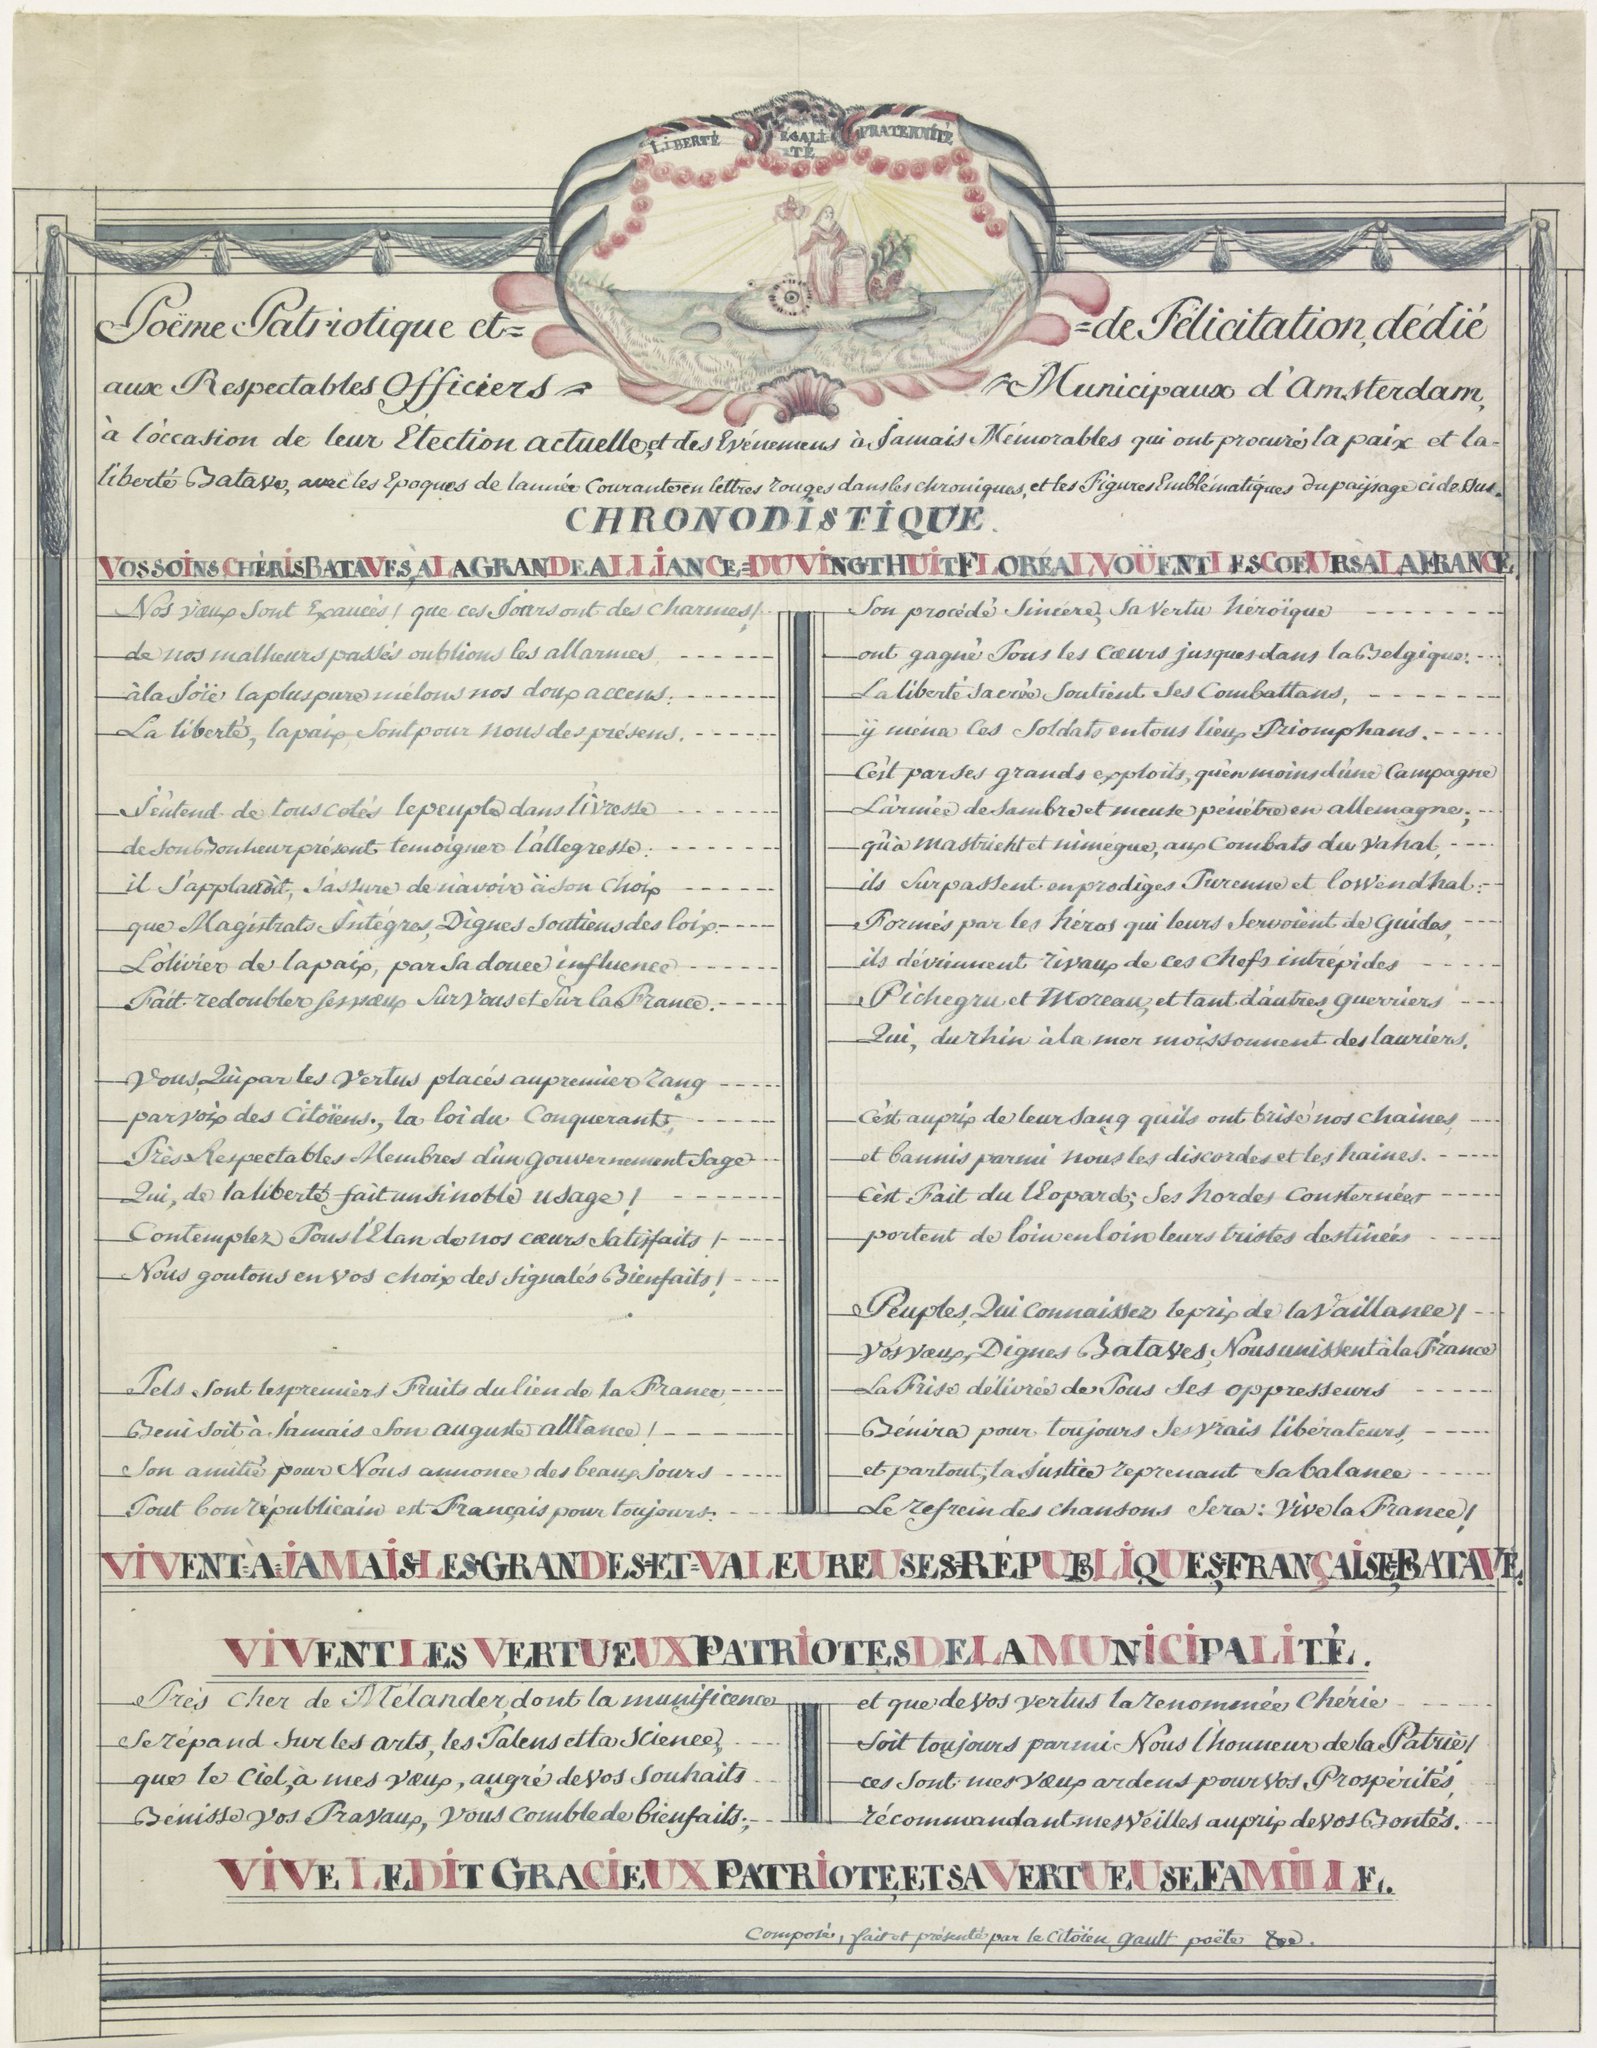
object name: drawing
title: Poëme Patriotique et de Félicitation, dédié aux Respectables Officiers Municipaux d'Amsterdam, à l'occasion de leur Election (...)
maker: gault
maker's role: dichter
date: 1795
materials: paper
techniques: brush, pen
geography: netherlands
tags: freedom, liberty; 'libertà' (ripa) (+ abstract concept represented by female figure), amsterdam, alliance with france (1795)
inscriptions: collector's mark: Lugt 2228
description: Frans vers ter gelegenheid van het Alliantiefeest te Amsterdam op 19 juni 1795. Opgedragen aan de nieuw verkozen provisionele representanten van het volk van Amsterdam. Bovenaan een cartouche met de Vrijheid, een tijdvers, daaronder het vers in twee kolommen, alles in de kleuren blauw en roze.